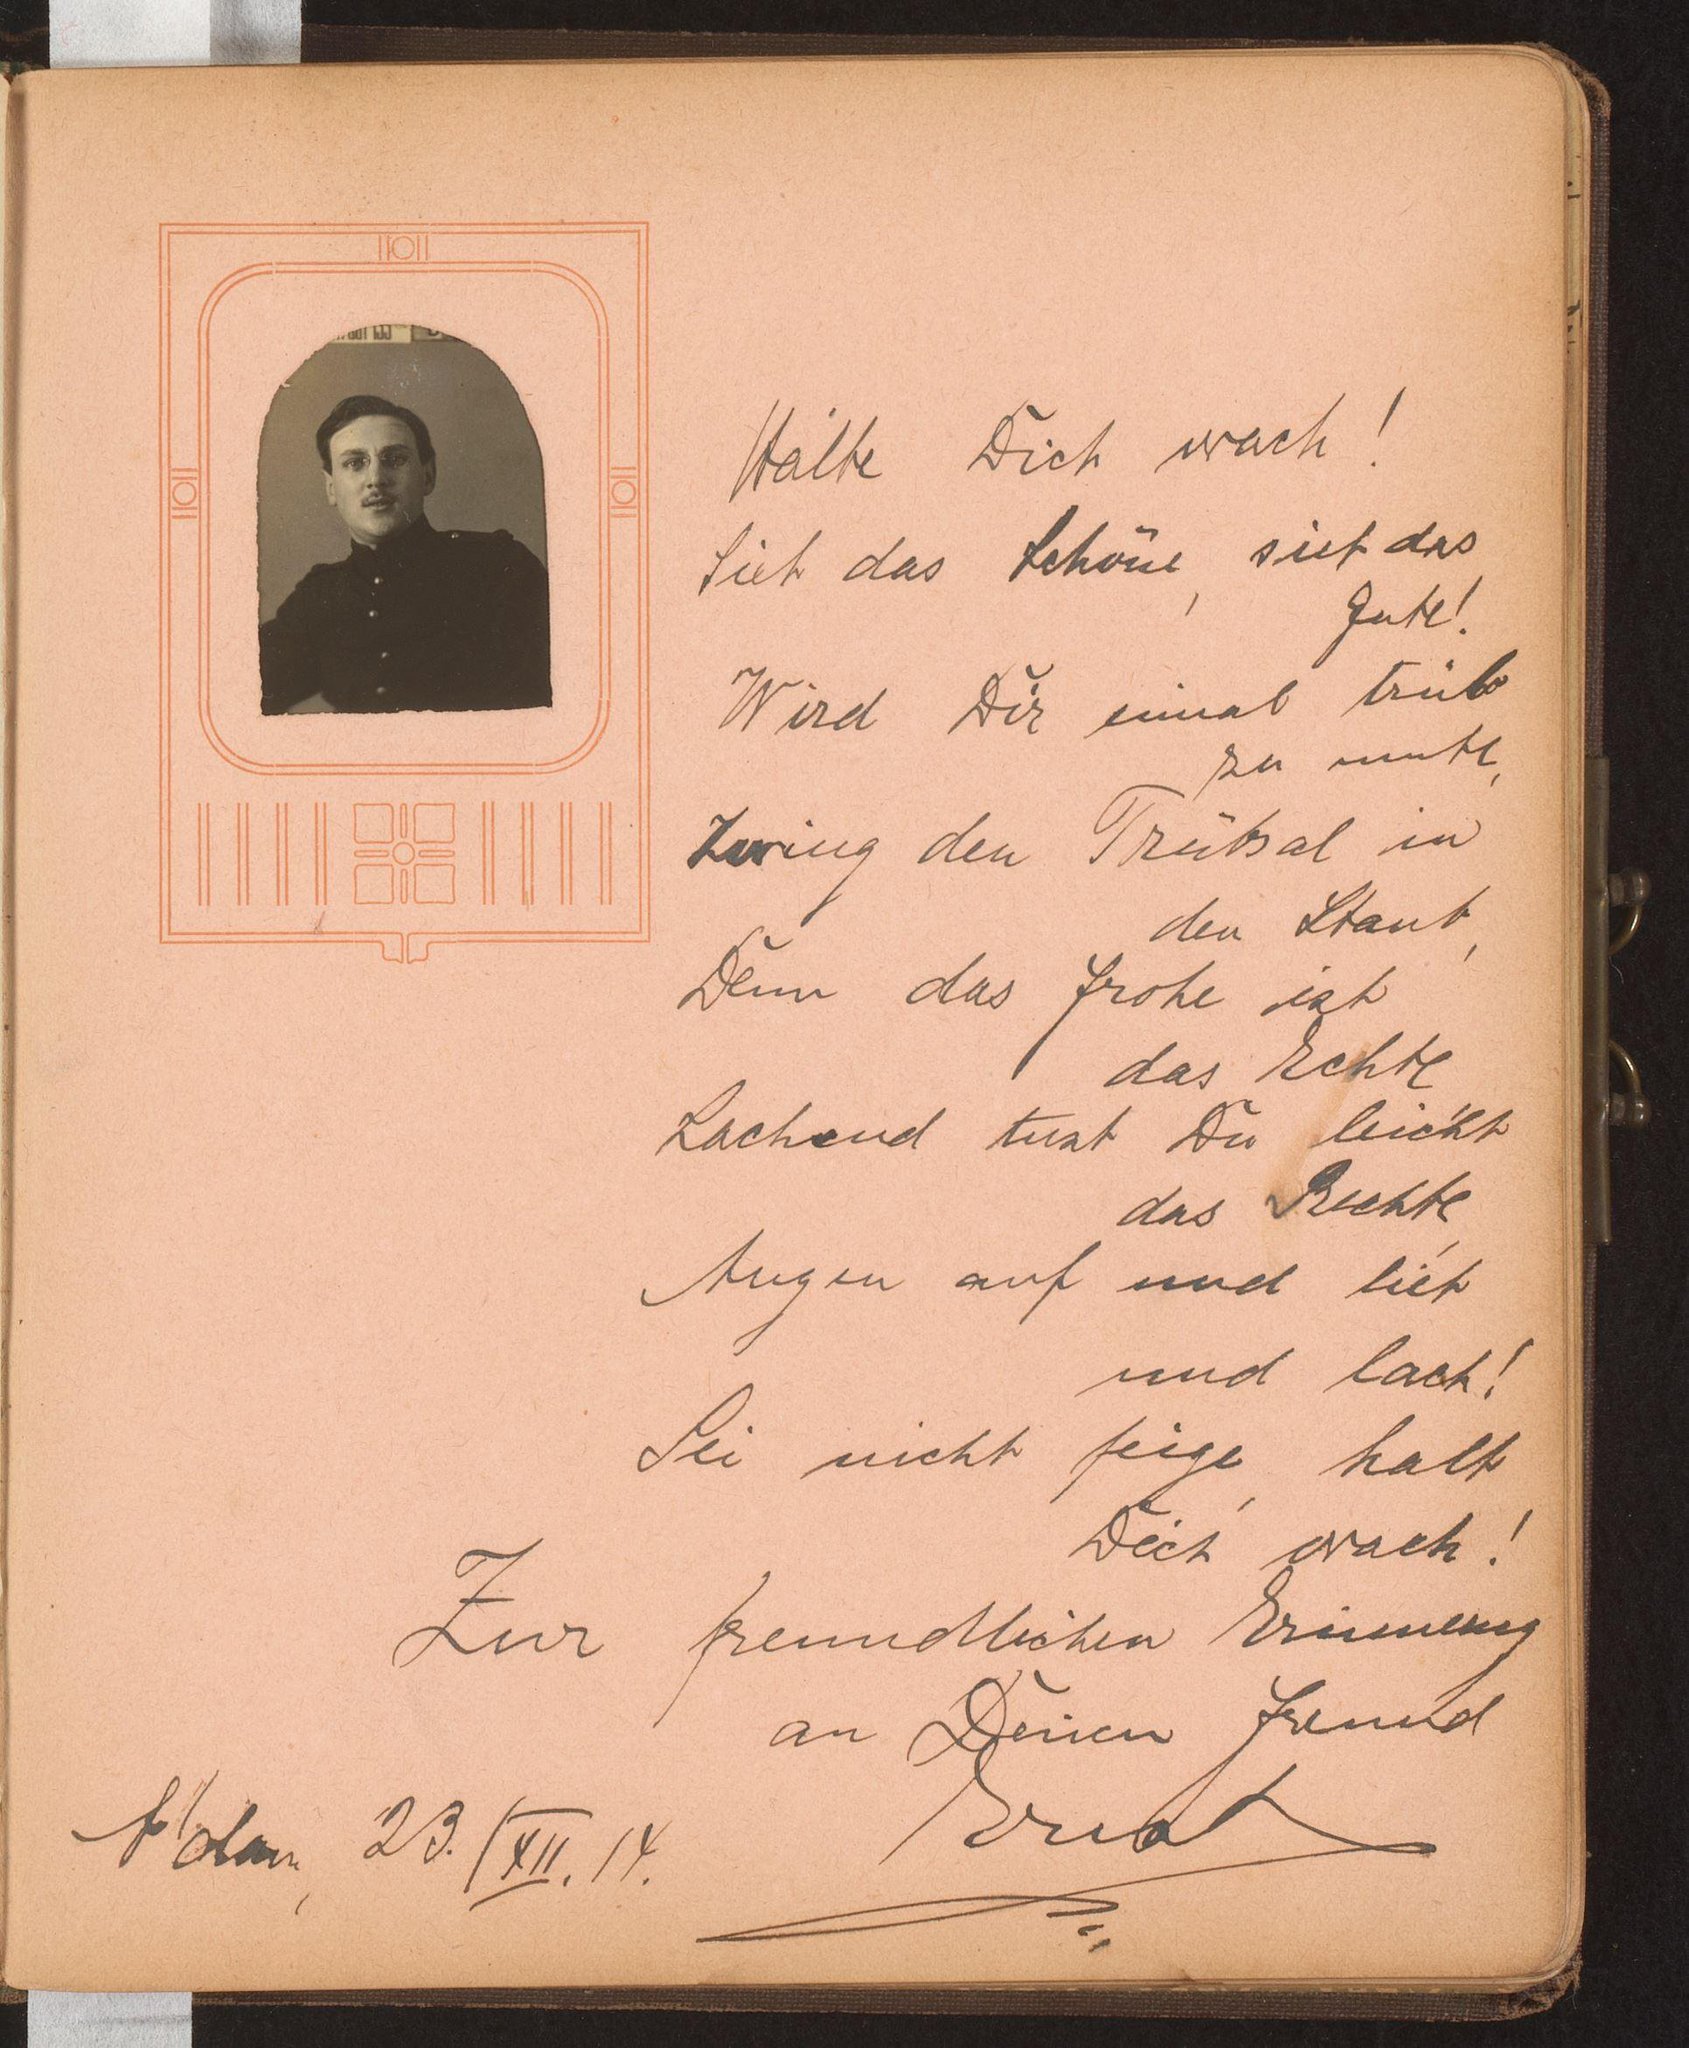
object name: snapshot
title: Portret van Ernst Elring met pince-nez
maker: Anonymous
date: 1900-1930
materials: photographic support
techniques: gelatin silver print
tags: eyeglasses, spectacles, historical persons, youth, adolescent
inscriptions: annotation: ‘Erst Elring/ [...]/ Hamburg/ [...]’